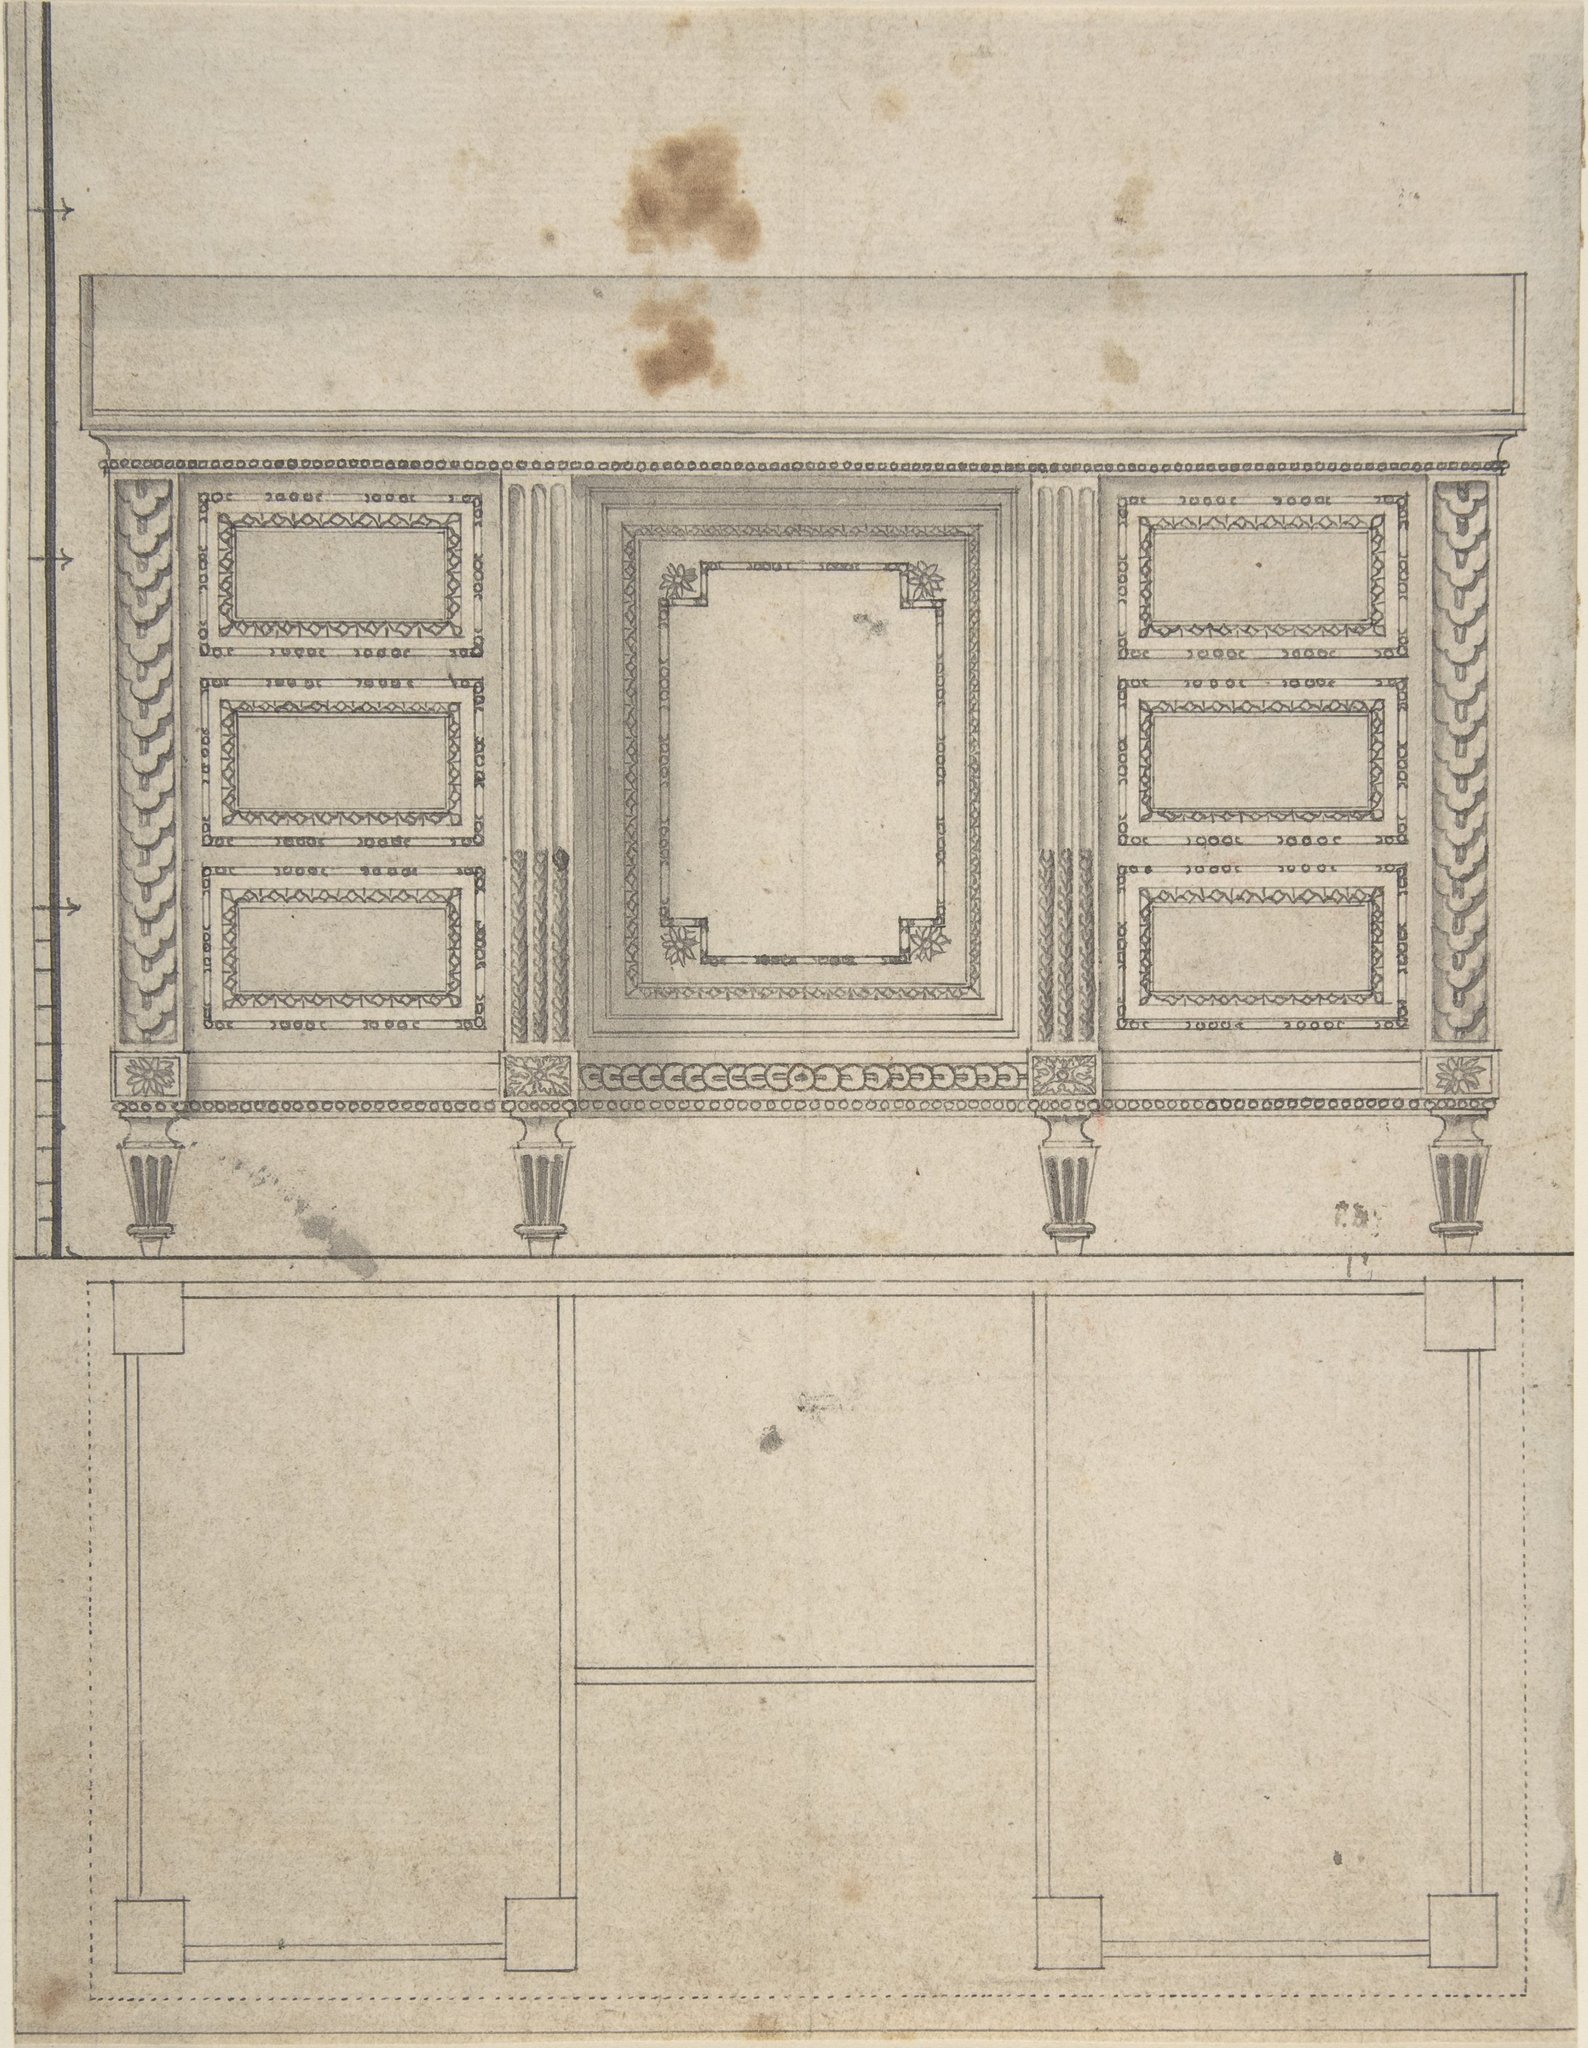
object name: drawing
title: Design for a Console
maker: anonymous, french, 18th century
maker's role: artist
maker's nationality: french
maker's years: 1700-1800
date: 1701-1800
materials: ink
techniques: brush, pen, wash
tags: furniture